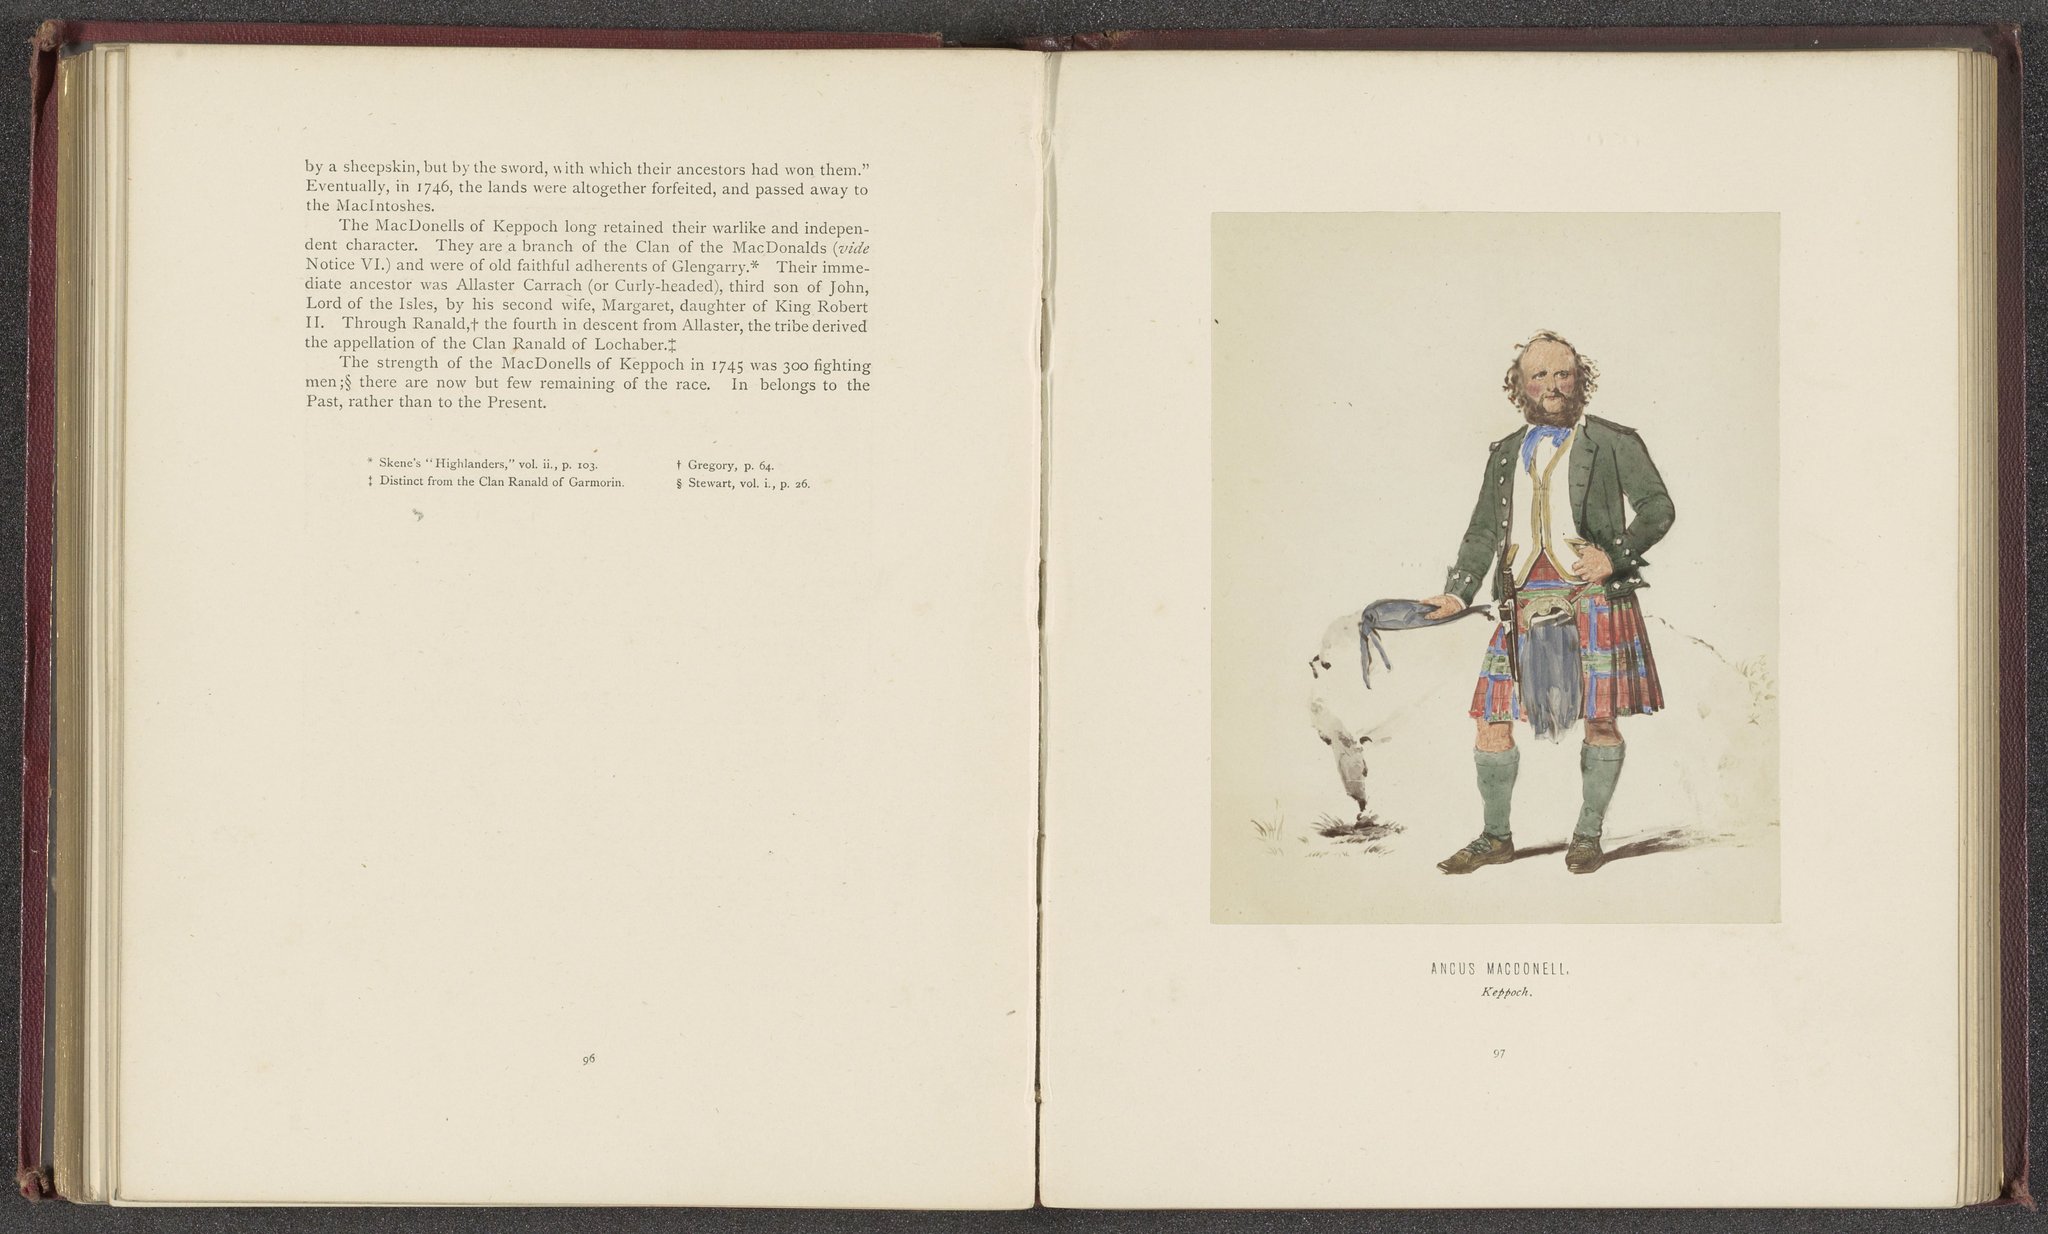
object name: reproduction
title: Fotoreproductie van een tekening van een portret van Angus Macdonell van de Clan MacDonald of Keppoch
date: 1860-1870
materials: photographic support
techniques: albumen print, hand coloring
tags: adult man, folk costume, regional costume